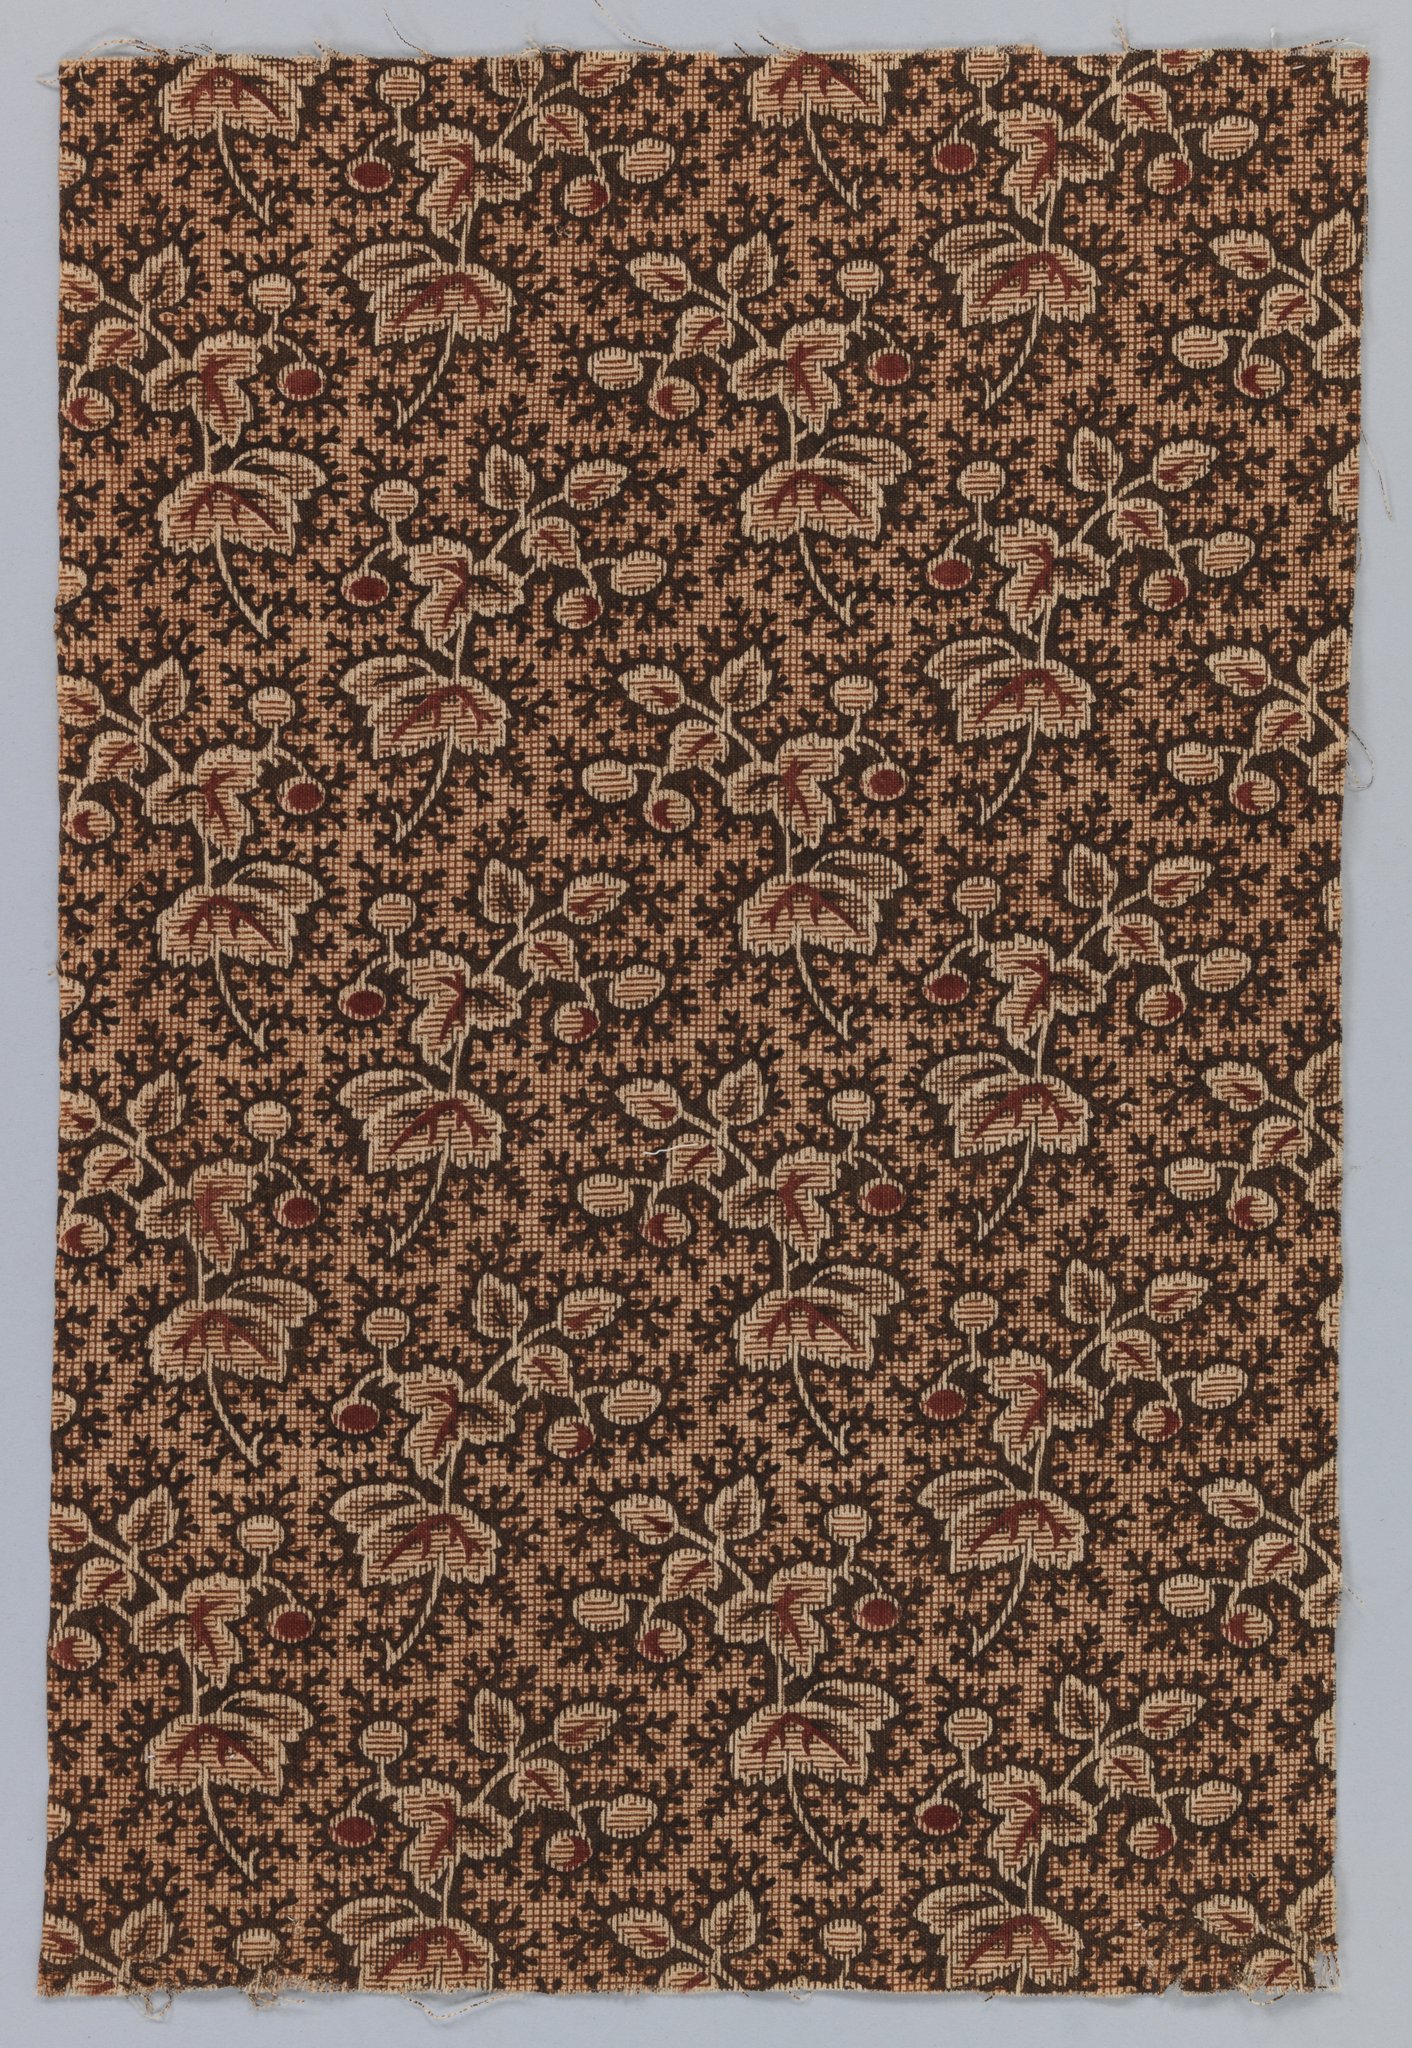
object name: piece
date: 1801-1900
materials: cotton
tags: leaves